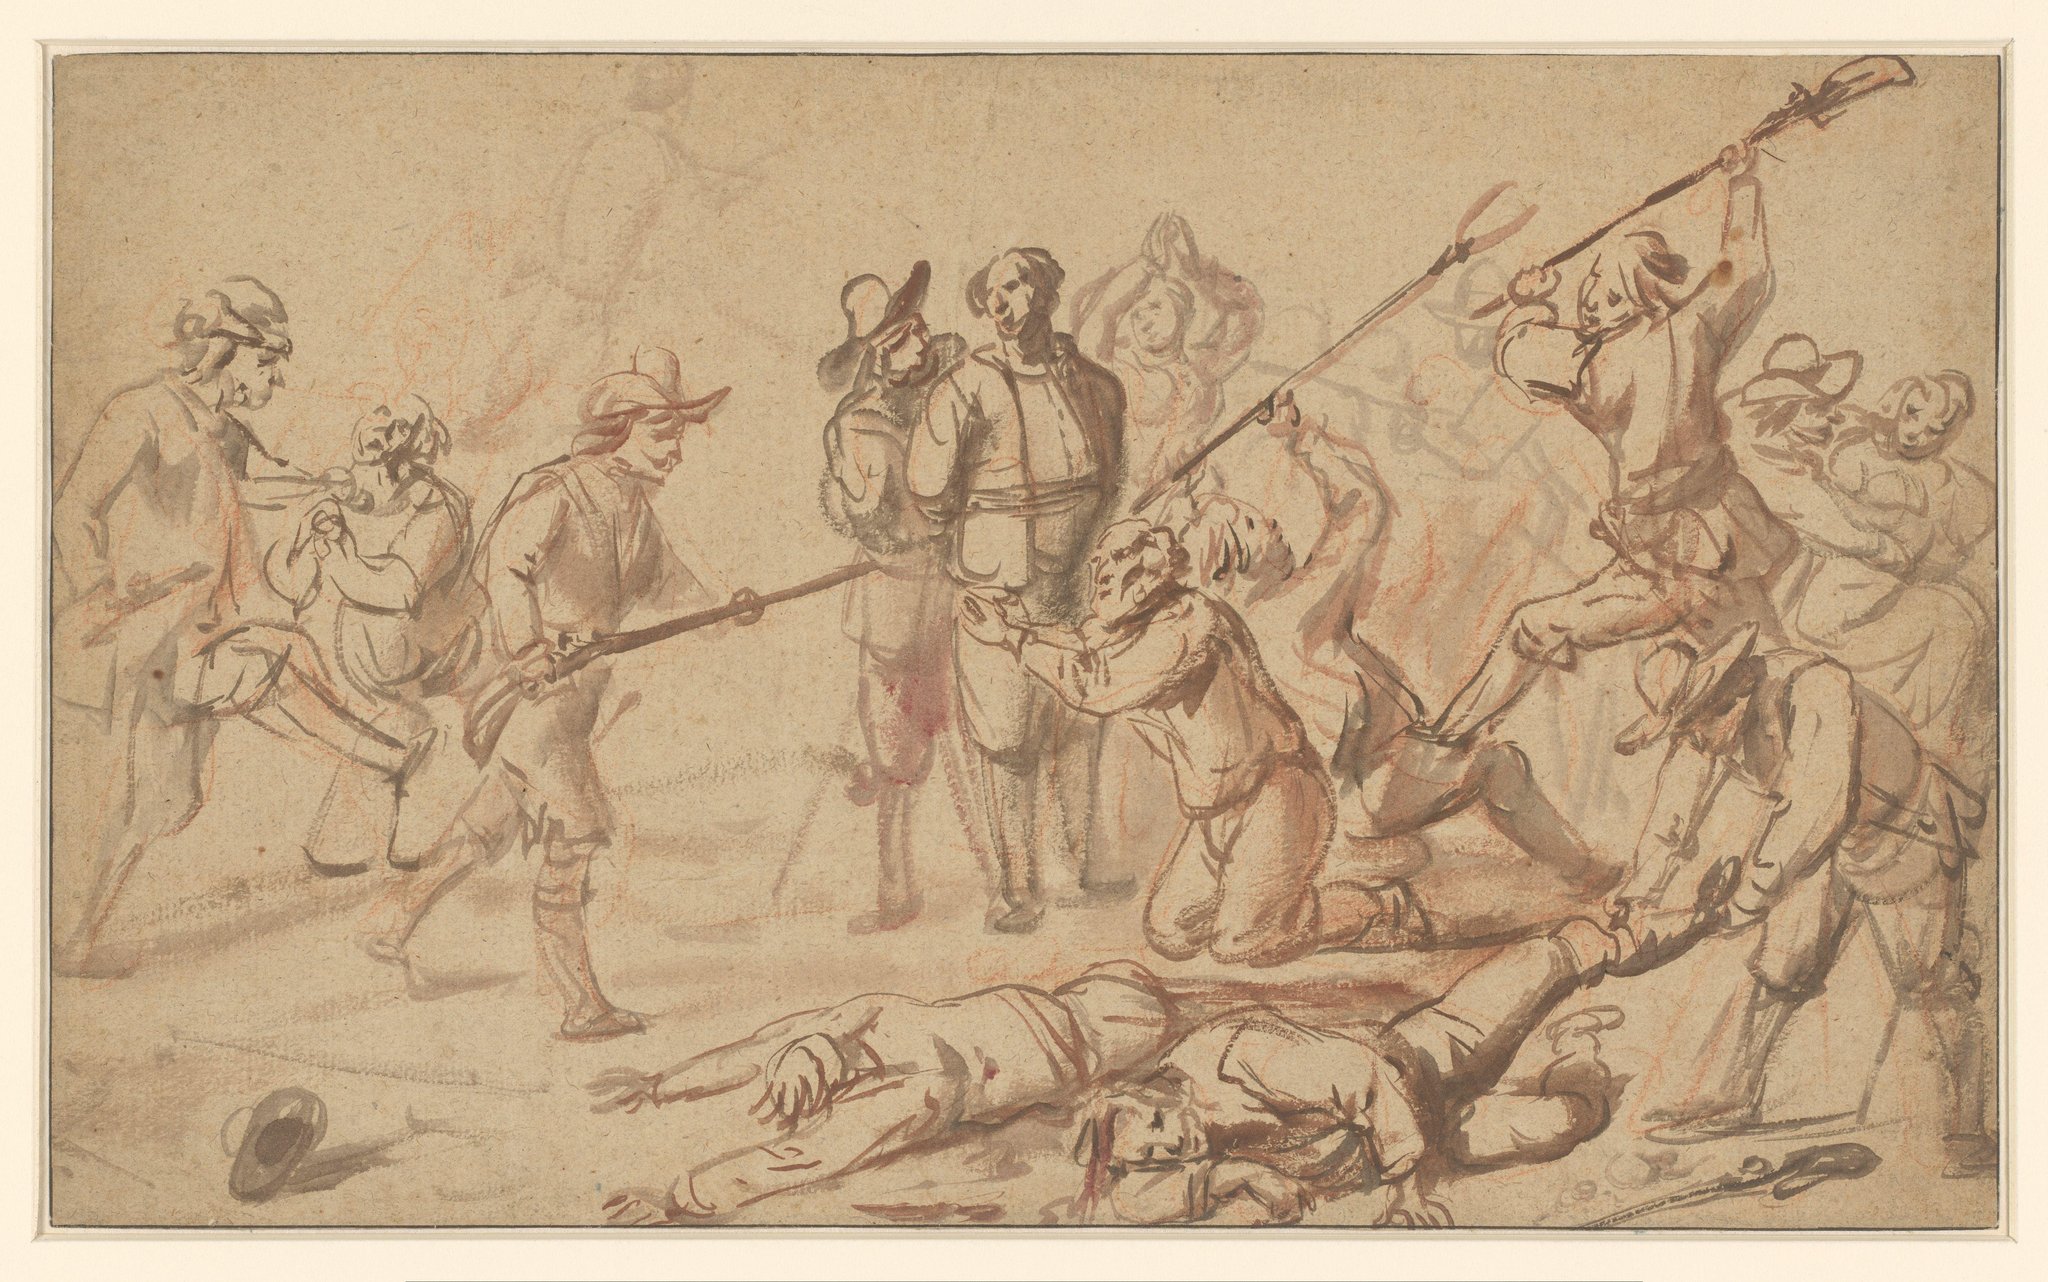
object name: drawing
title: Overval op boeren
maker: cornelis de wael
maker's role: draughtsman, print maker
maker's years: 1592-1667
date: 1602-1667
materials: chalk, paper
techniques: brush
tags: fight between farmers and soldiers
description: Overval op boeren, die worden vastgebonden, gedood en beroofd.